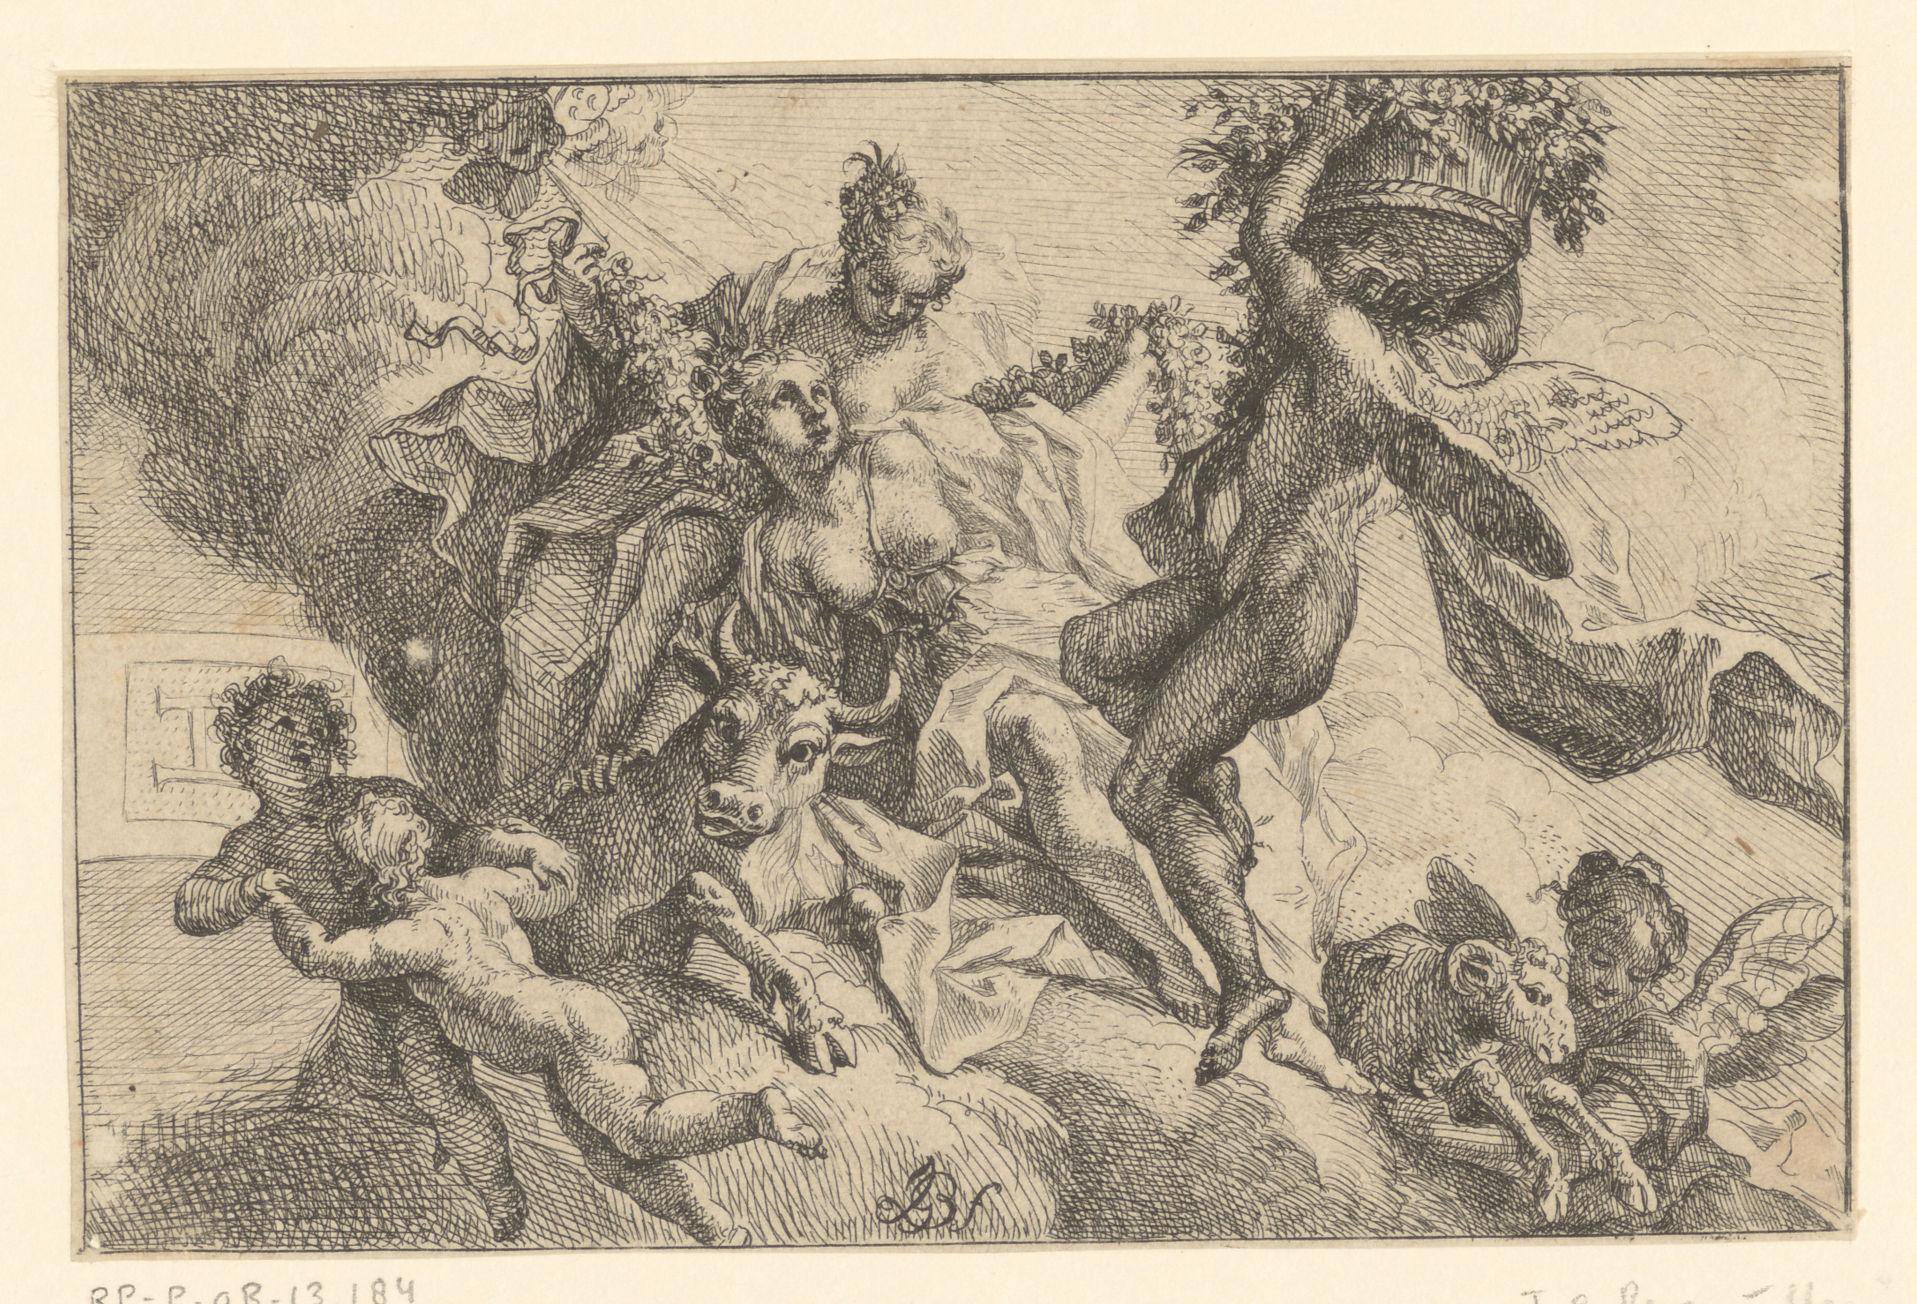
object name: print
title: Vier seizoenen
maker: johann georg bergmüller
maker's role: print maker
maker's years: 1688-1762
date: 1708-1762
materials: paper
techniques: etching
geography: germany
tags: wind as a human face, blowing with rounded cheeks, cow, garland, wreath, sheep, gemini (zodiacal sign of may), cupids: 'amores', 'amoretti', 'putti'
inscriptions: collector's mark: Lugt 2227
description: Op een wolk zitten twee vrouwen met bloemguirlandes. De hand van de voorste vrouw ligt op de rug van een koe; rechts een meisje met vleugels naast een schaap. In het midden komt een man met een mand met bloemen aangevlogen. Achter twee putti het sterrenbeeld Gemini.